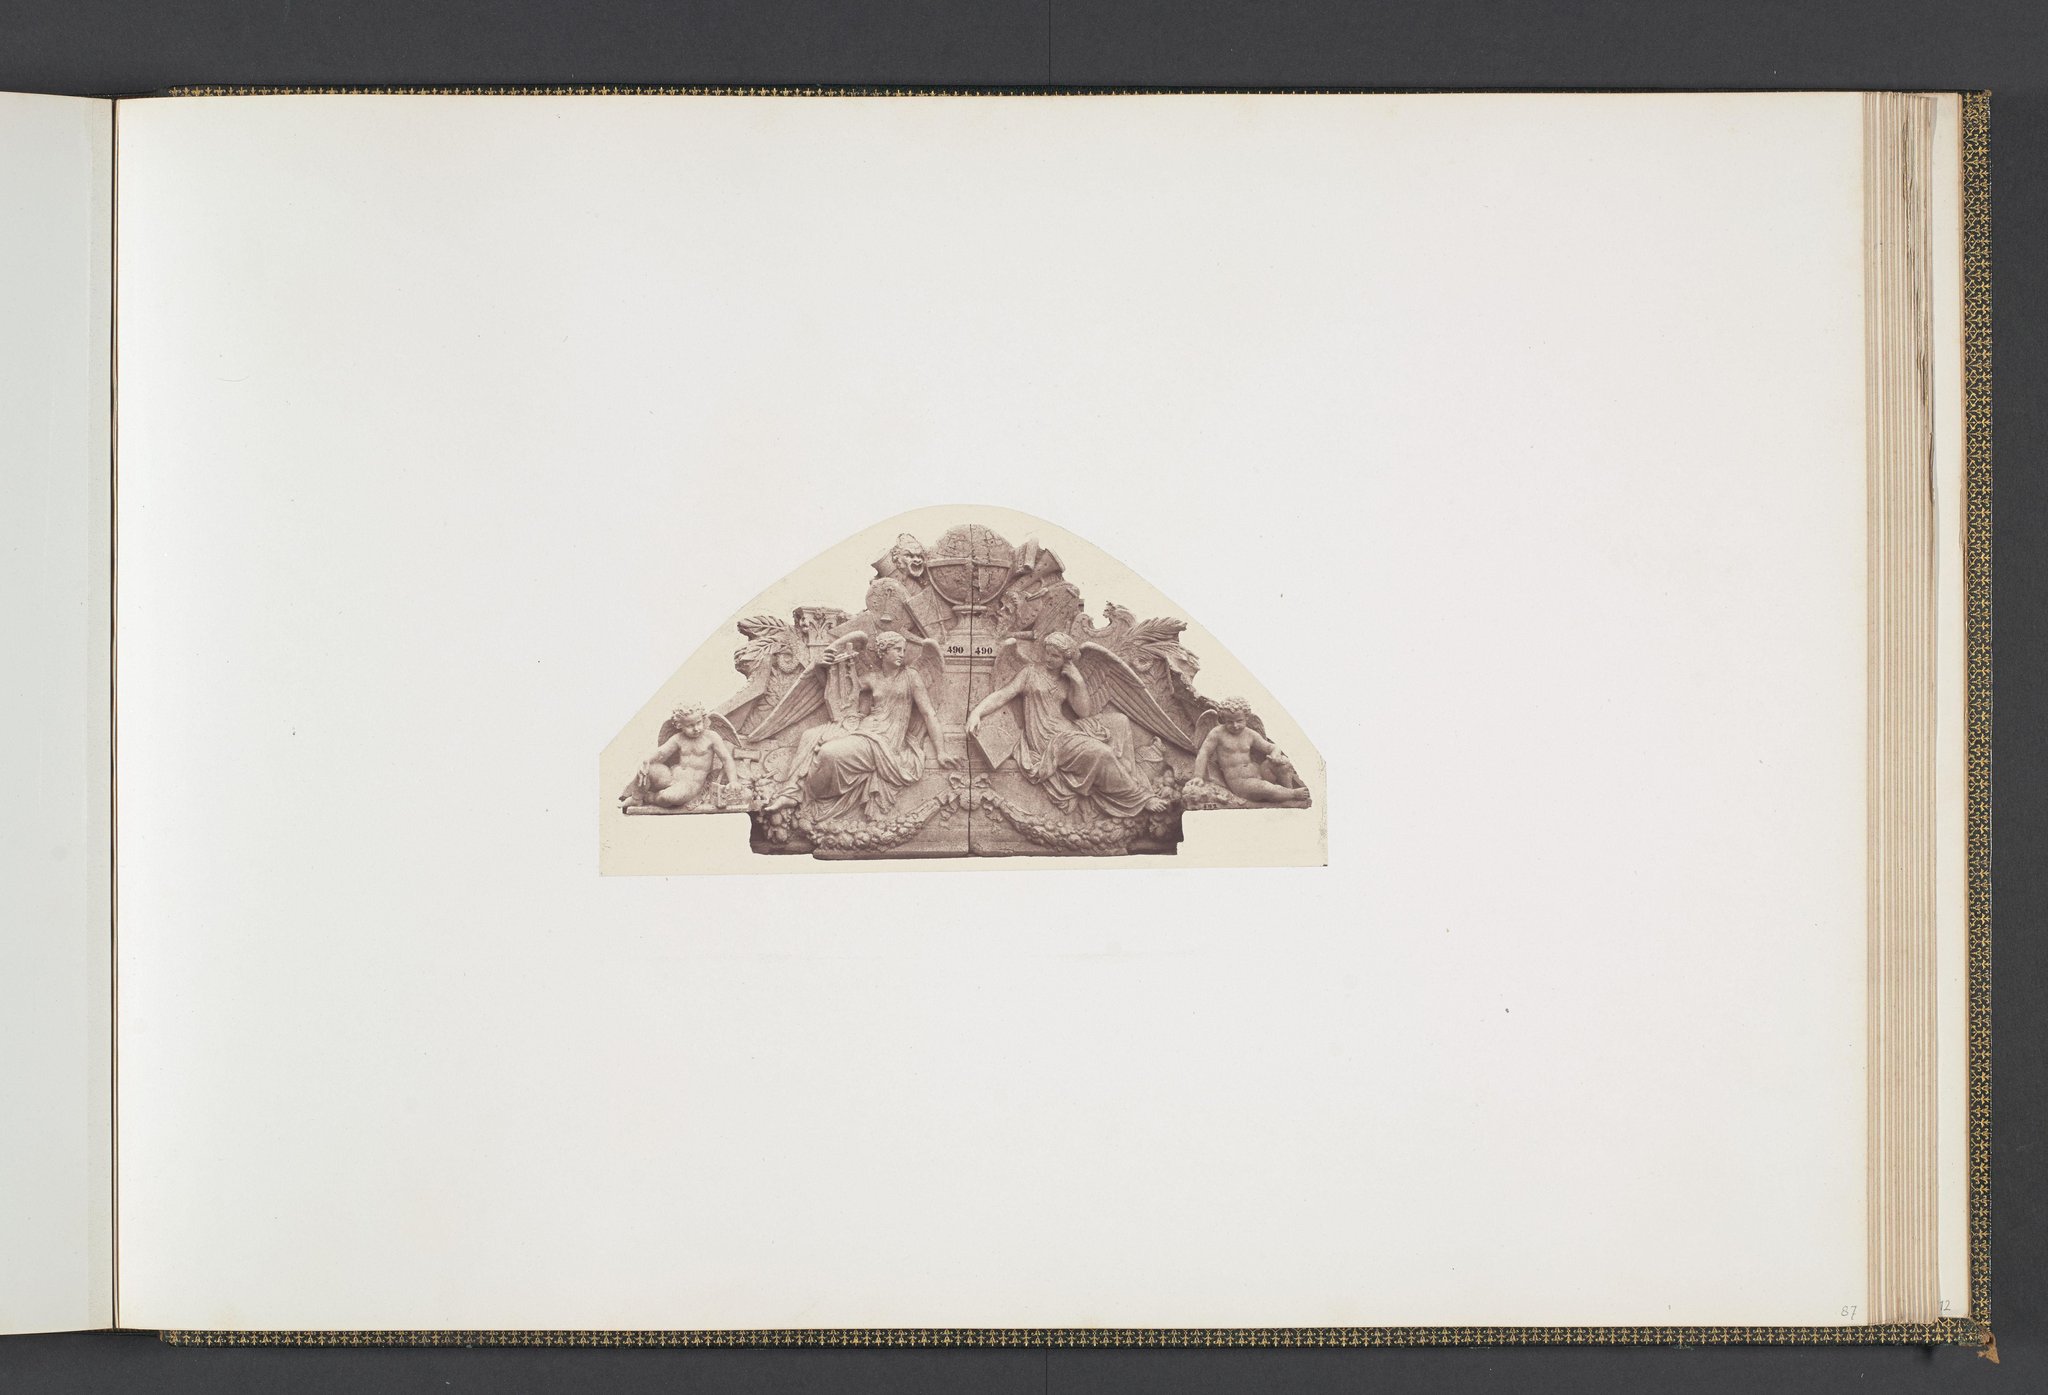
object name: album leaf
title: Gipsmodellen voor beeldhouwwerken op het Palais du Louvre: "Les Arts et les Sciences" door François Jouffroy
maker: édouard denis baldus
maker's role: fotograaf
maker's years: 1813-1889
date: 1855-1857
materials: paper, photographic support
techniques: salted paper print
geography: paris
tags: piece of sculpture, reproduction of a piece of sculpture, permanent exhibition, museum, paris, tuileries palace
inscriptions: number: ‘490 beide’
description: Onderdeel van Réunion des Tuileries au Louvre 1852-1857, album 2.